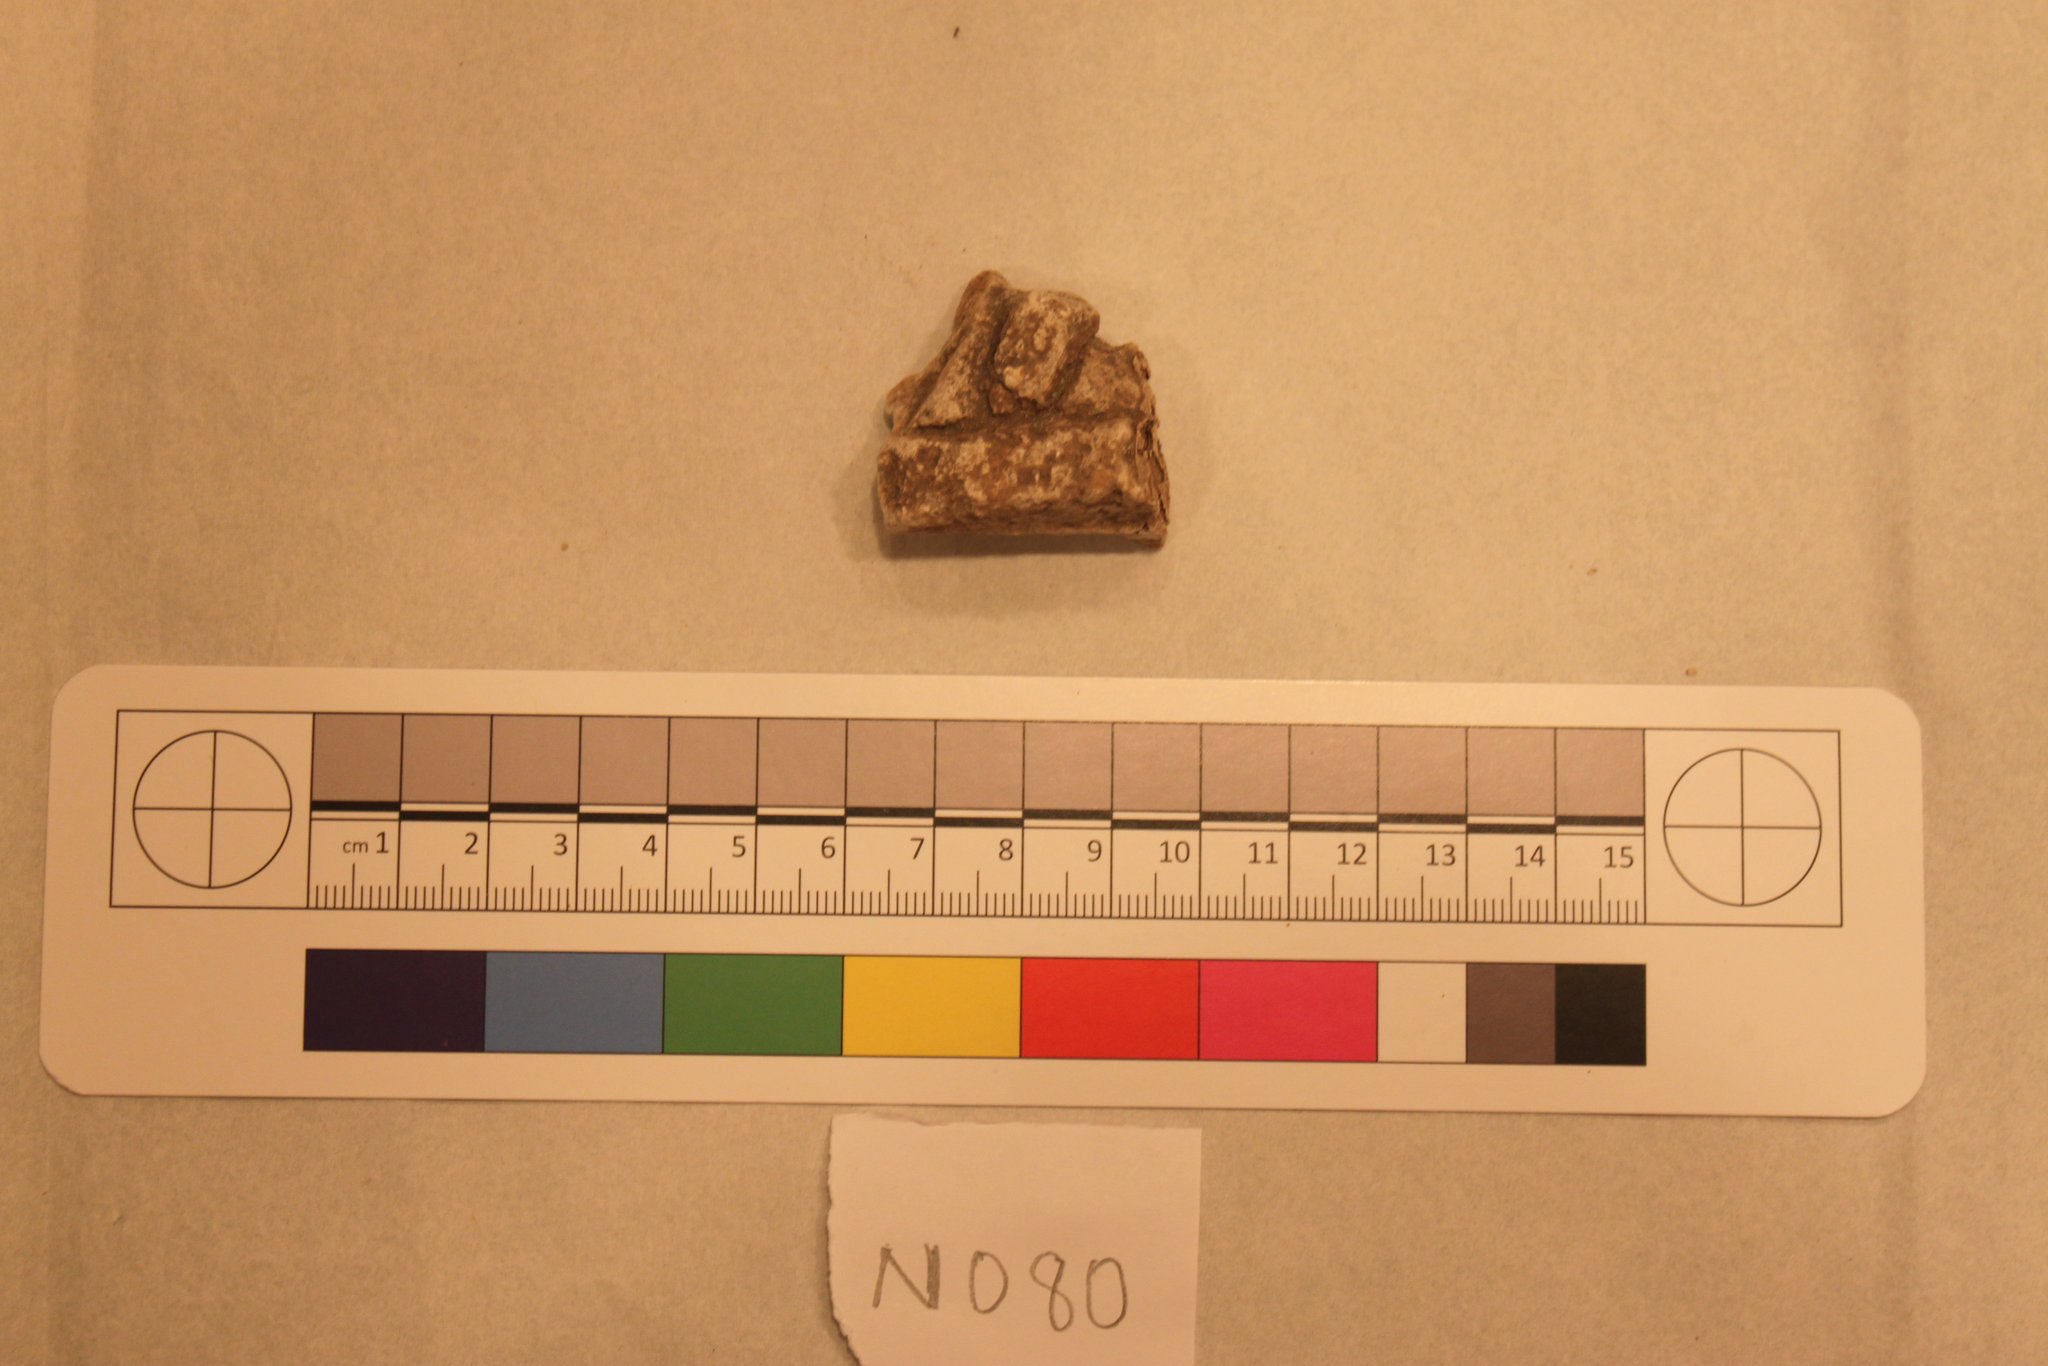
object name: fragment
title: Stucco Fragment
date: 701-1200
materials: plaster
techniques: carving, painting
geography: iran